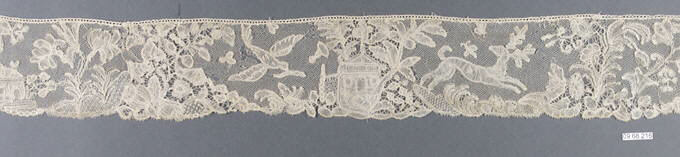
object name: strip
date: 1701-1800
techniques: lace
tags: birds,deer,flowers